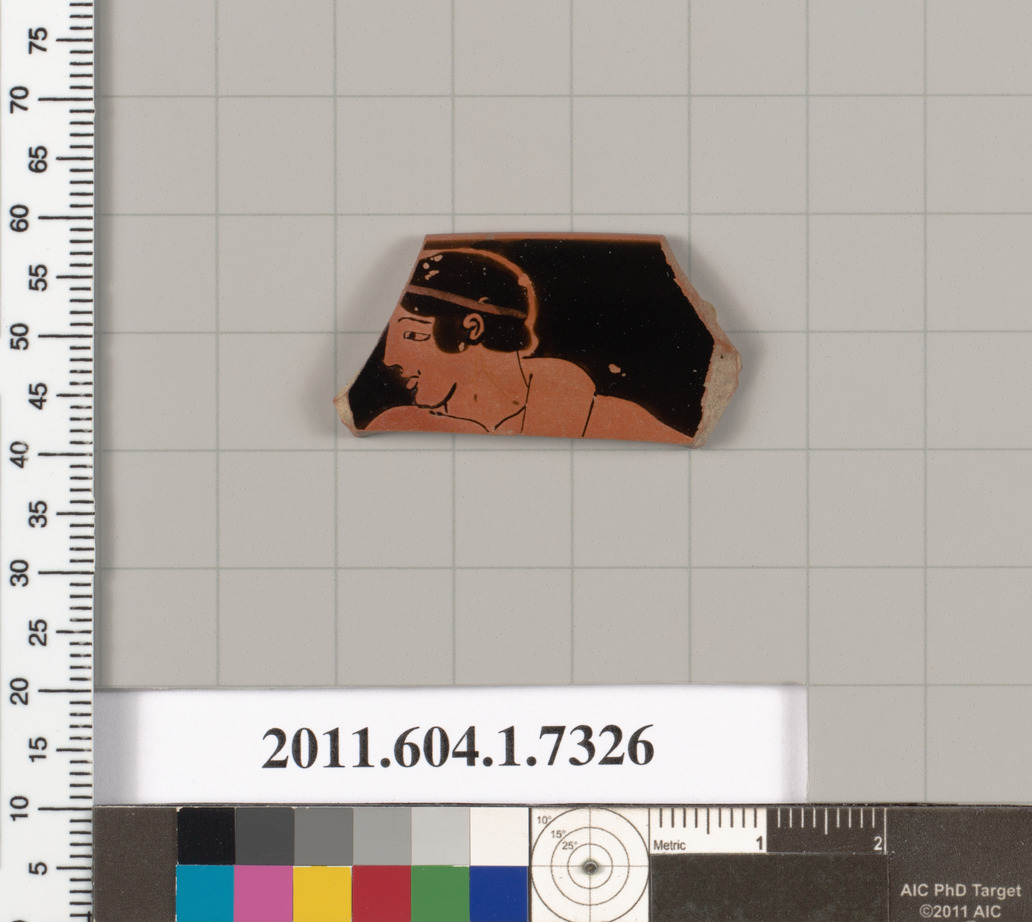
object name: kylix fragment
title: Terracotta rim fragment of a kylix (drinking cup)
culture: greek, attic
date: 500-480 BCE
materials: terracotta